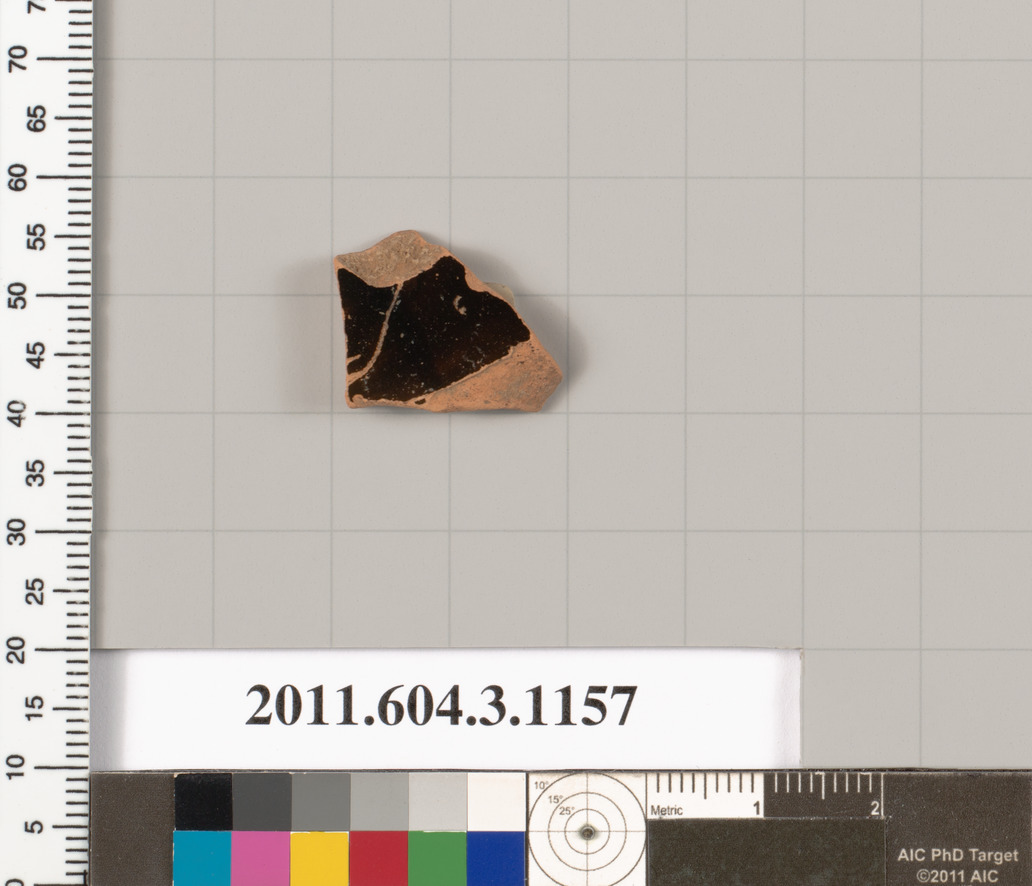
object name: mastoid or kyathos fragment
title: Terracotta fragment of a mastoid (drinking cup with narrow base) or a kyathos (cup-shaped ladle)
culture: greek, attic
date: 534-468 BCE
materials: terracotta